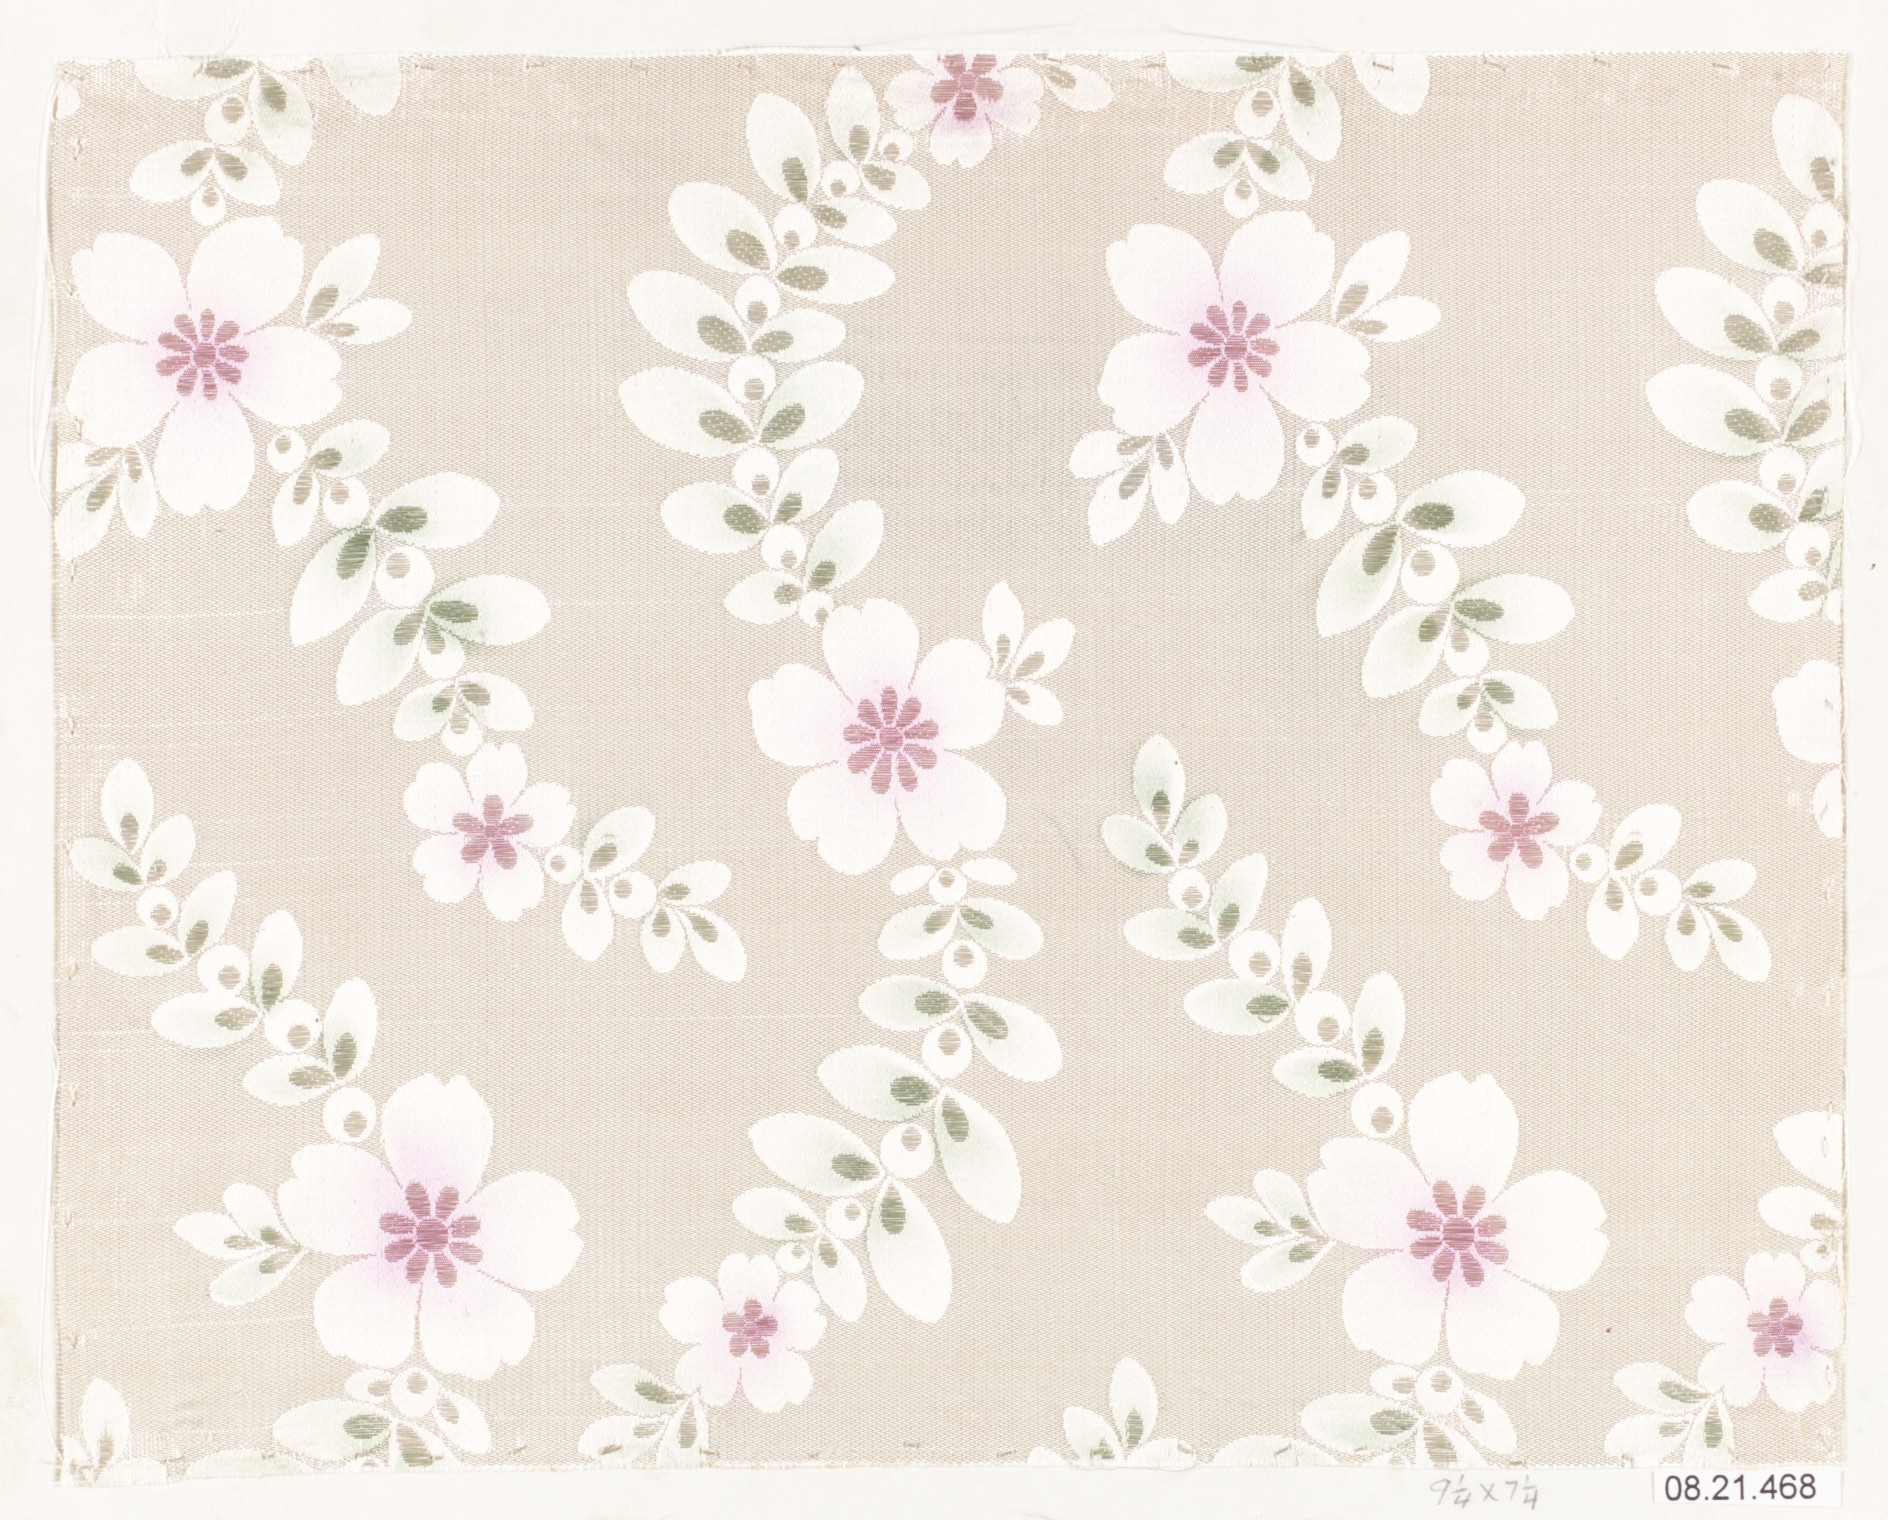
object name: textile sample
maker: Anonymous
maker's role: designer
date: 1900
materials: silk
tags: flowers,leaves